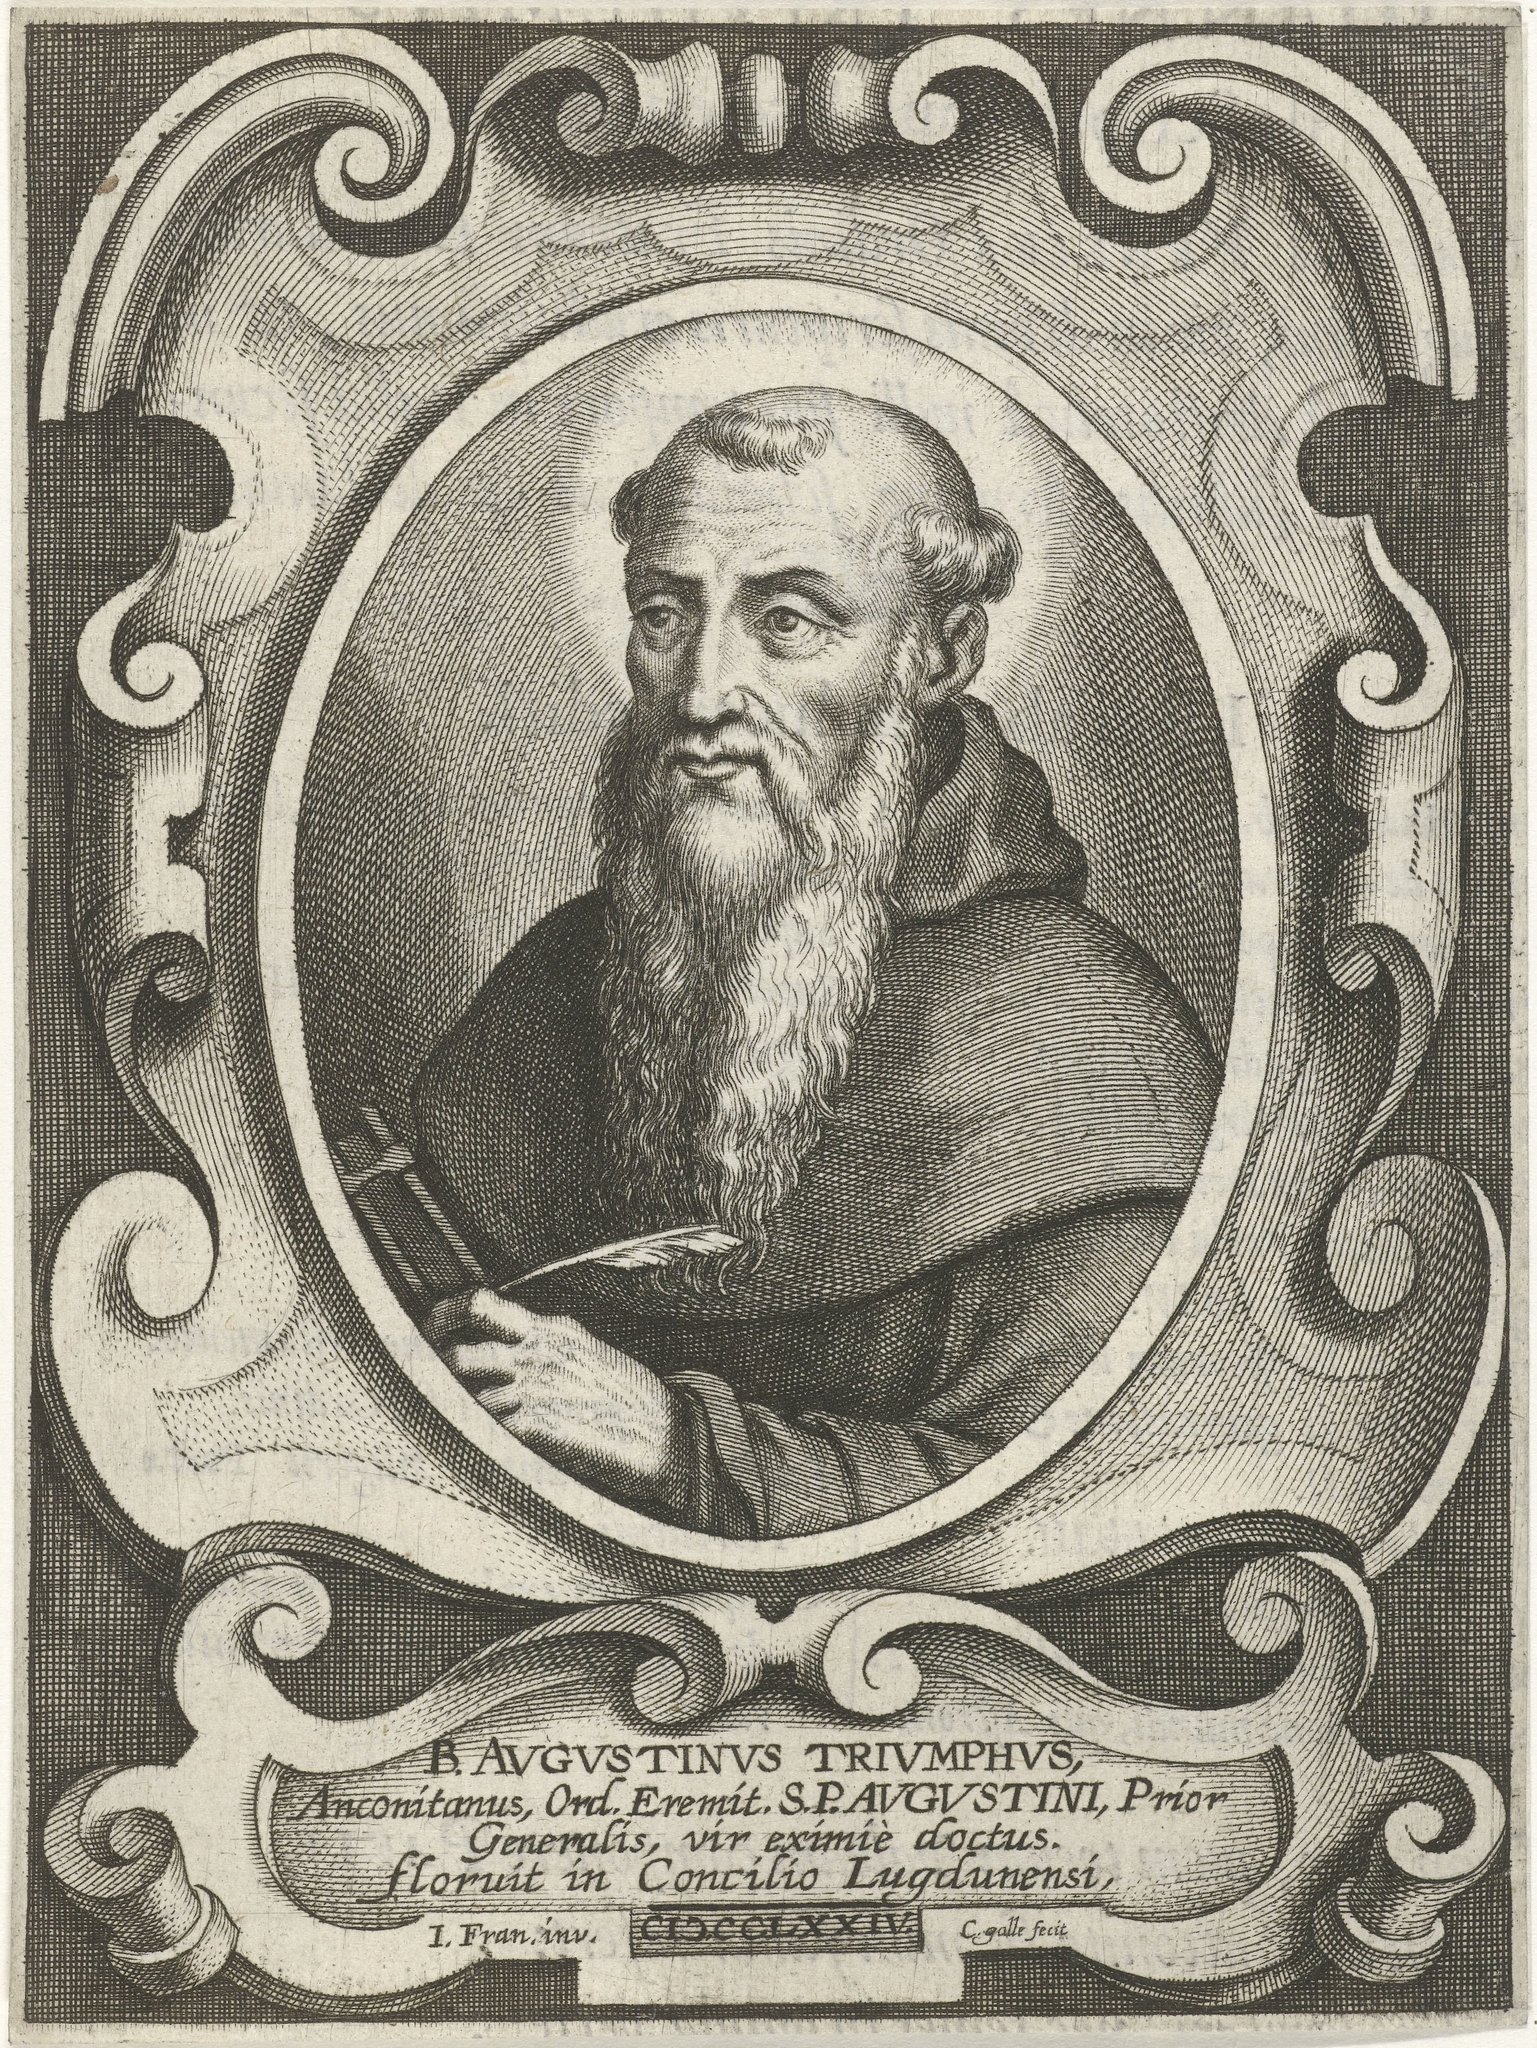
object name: book illustration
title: Portret van de Augustijn Augustinus de Ancona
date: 1636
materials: paper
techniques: engraving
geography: southern netherlands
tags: monastic orders, monastic life ~ roman catholic church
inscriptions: collector's mark: Lugt 2228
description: Boekillustratie voor: C. Curtius, Virorum illustrium ex ordine Eremitarum D. Augustini elogia , Antwerpen: J. Cnobbaert, 1636.